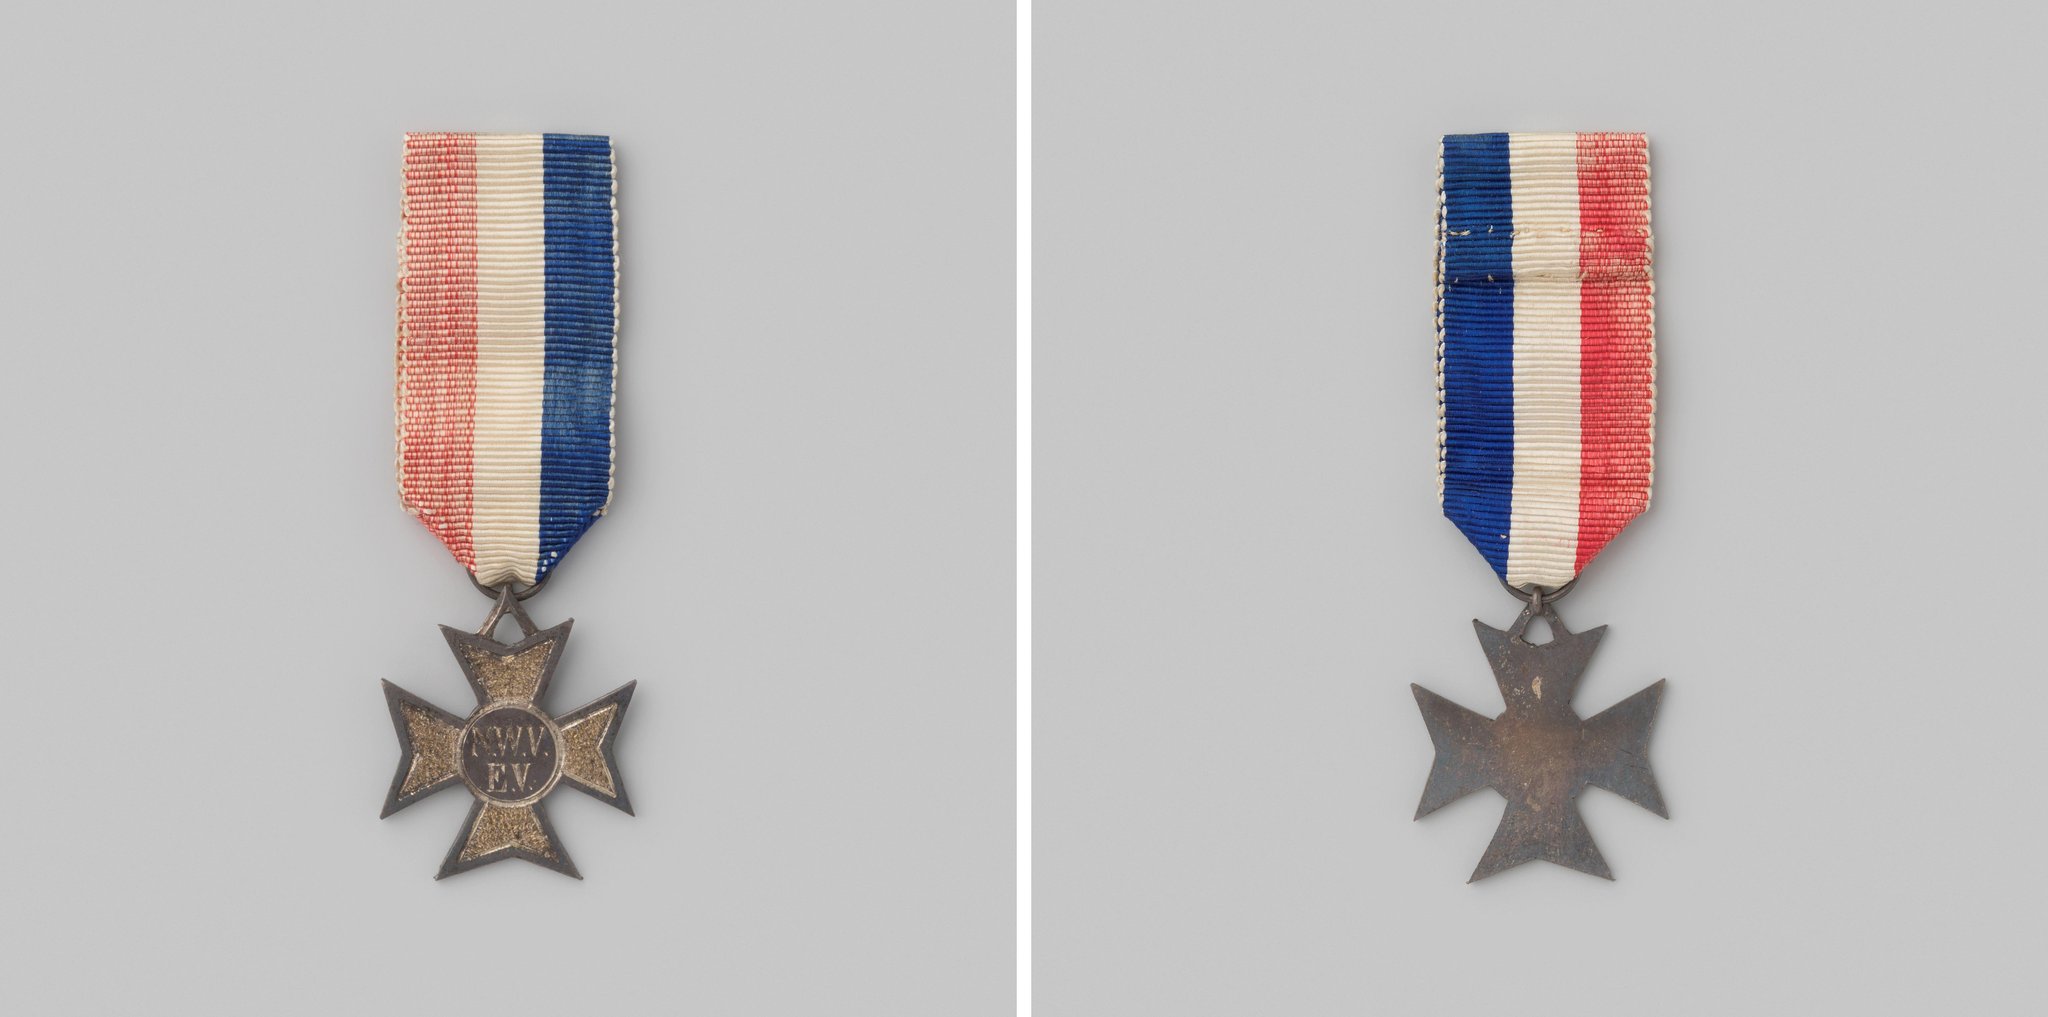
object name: insignia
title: Draagteken voor de schutterij, in de vorm van een kruis met de letters N.W.V.E.V.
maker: Anonymous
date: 1880-1899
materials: metal, textile